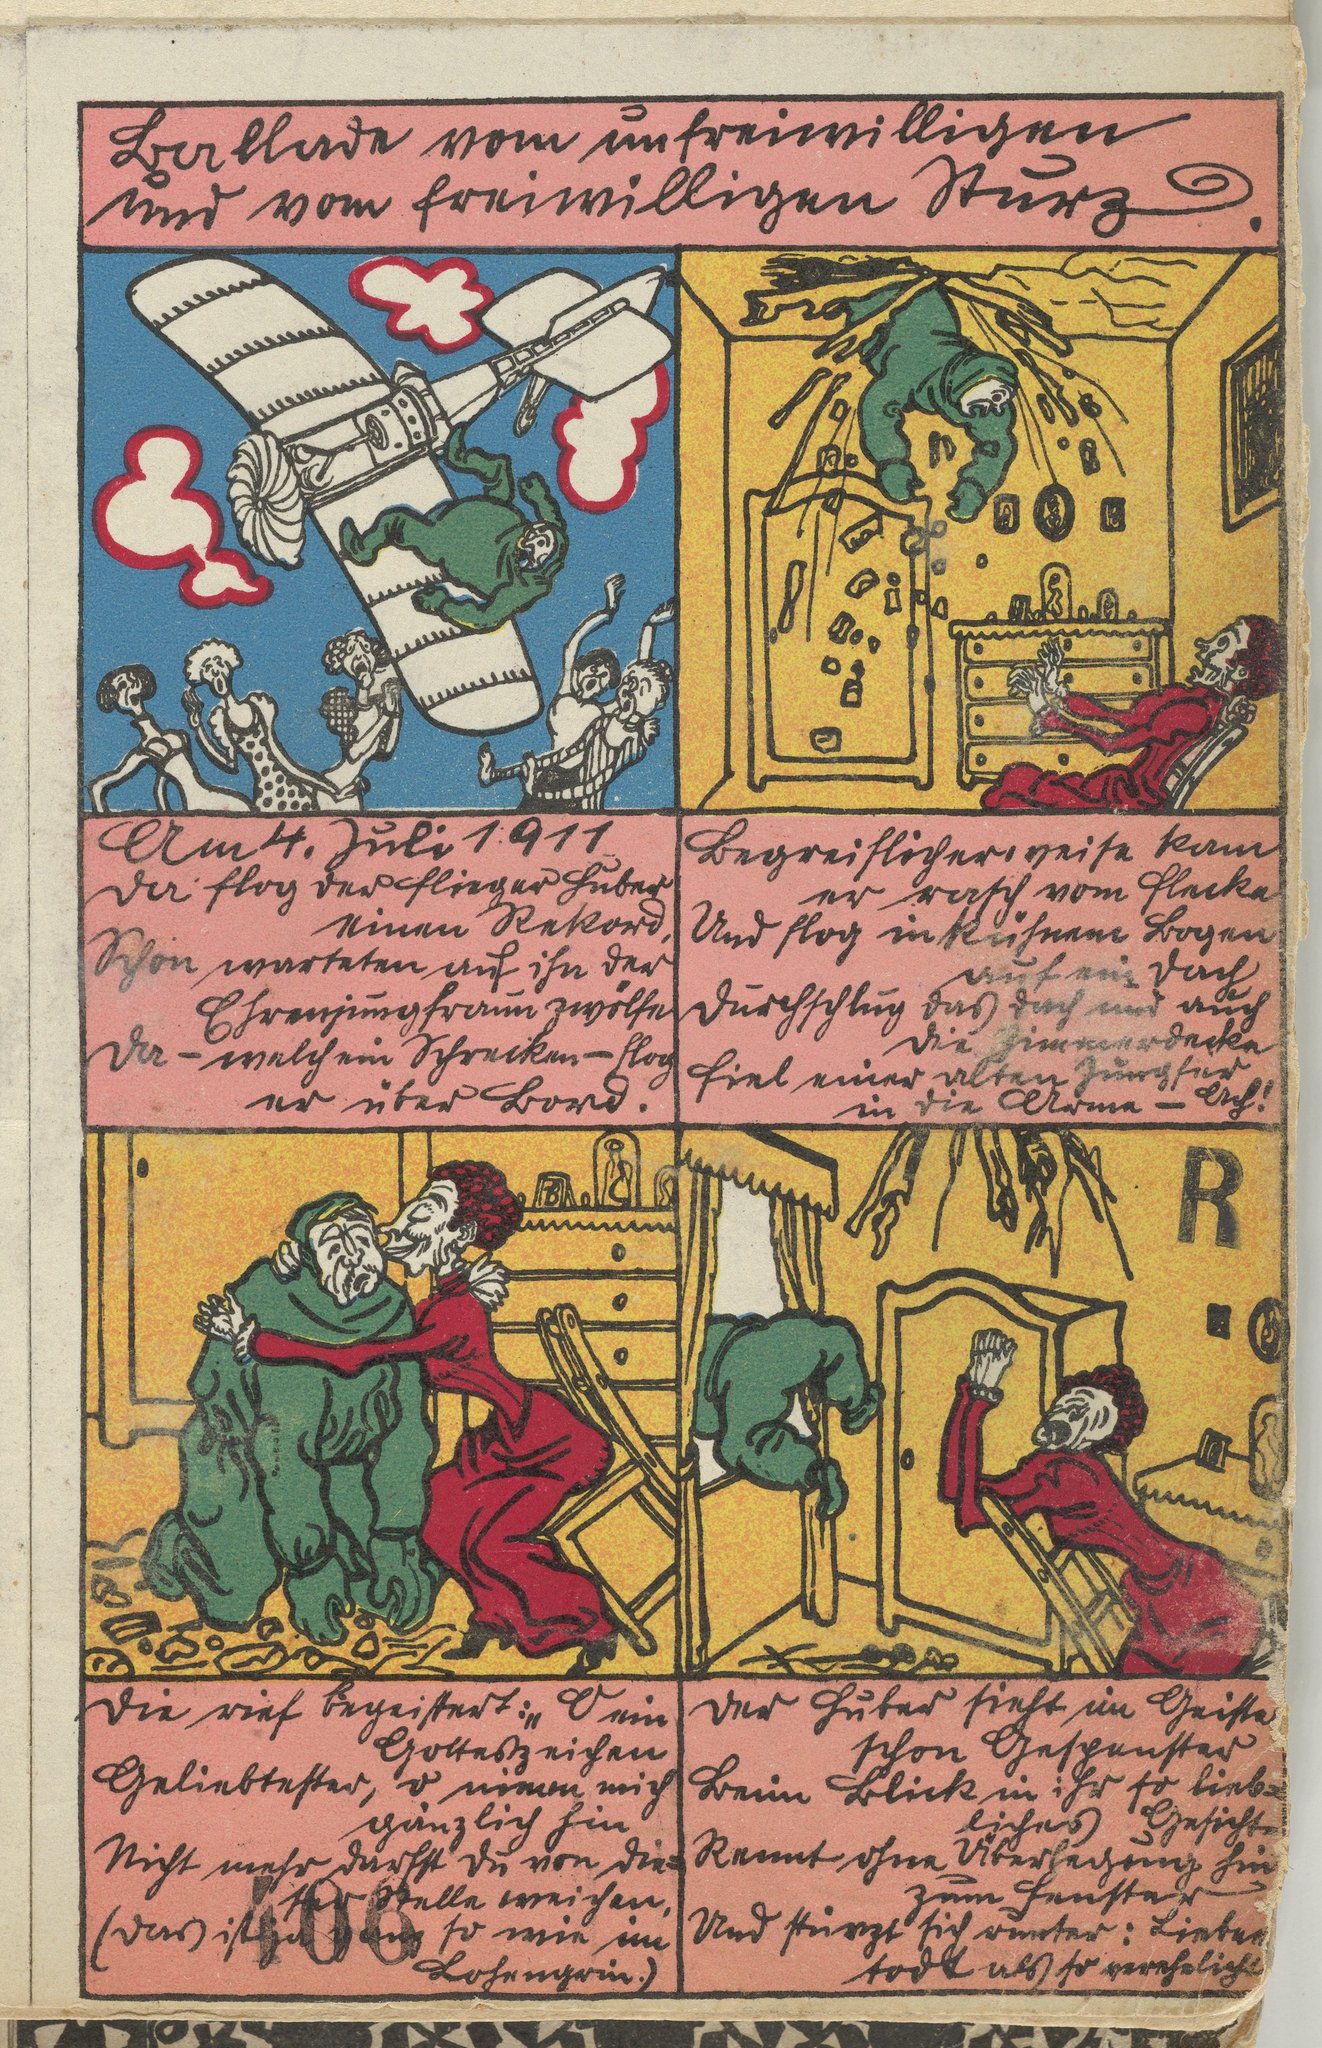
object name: print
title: Ballad of the Involuntary and Voluntary Fall (Ballade vom unfreiwilligen und vom freiwilligen Sturz)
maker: moriz jung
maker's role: artist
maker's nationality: austrian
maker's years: 1885-1915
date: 1911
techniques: lithograph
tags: men,women,planes